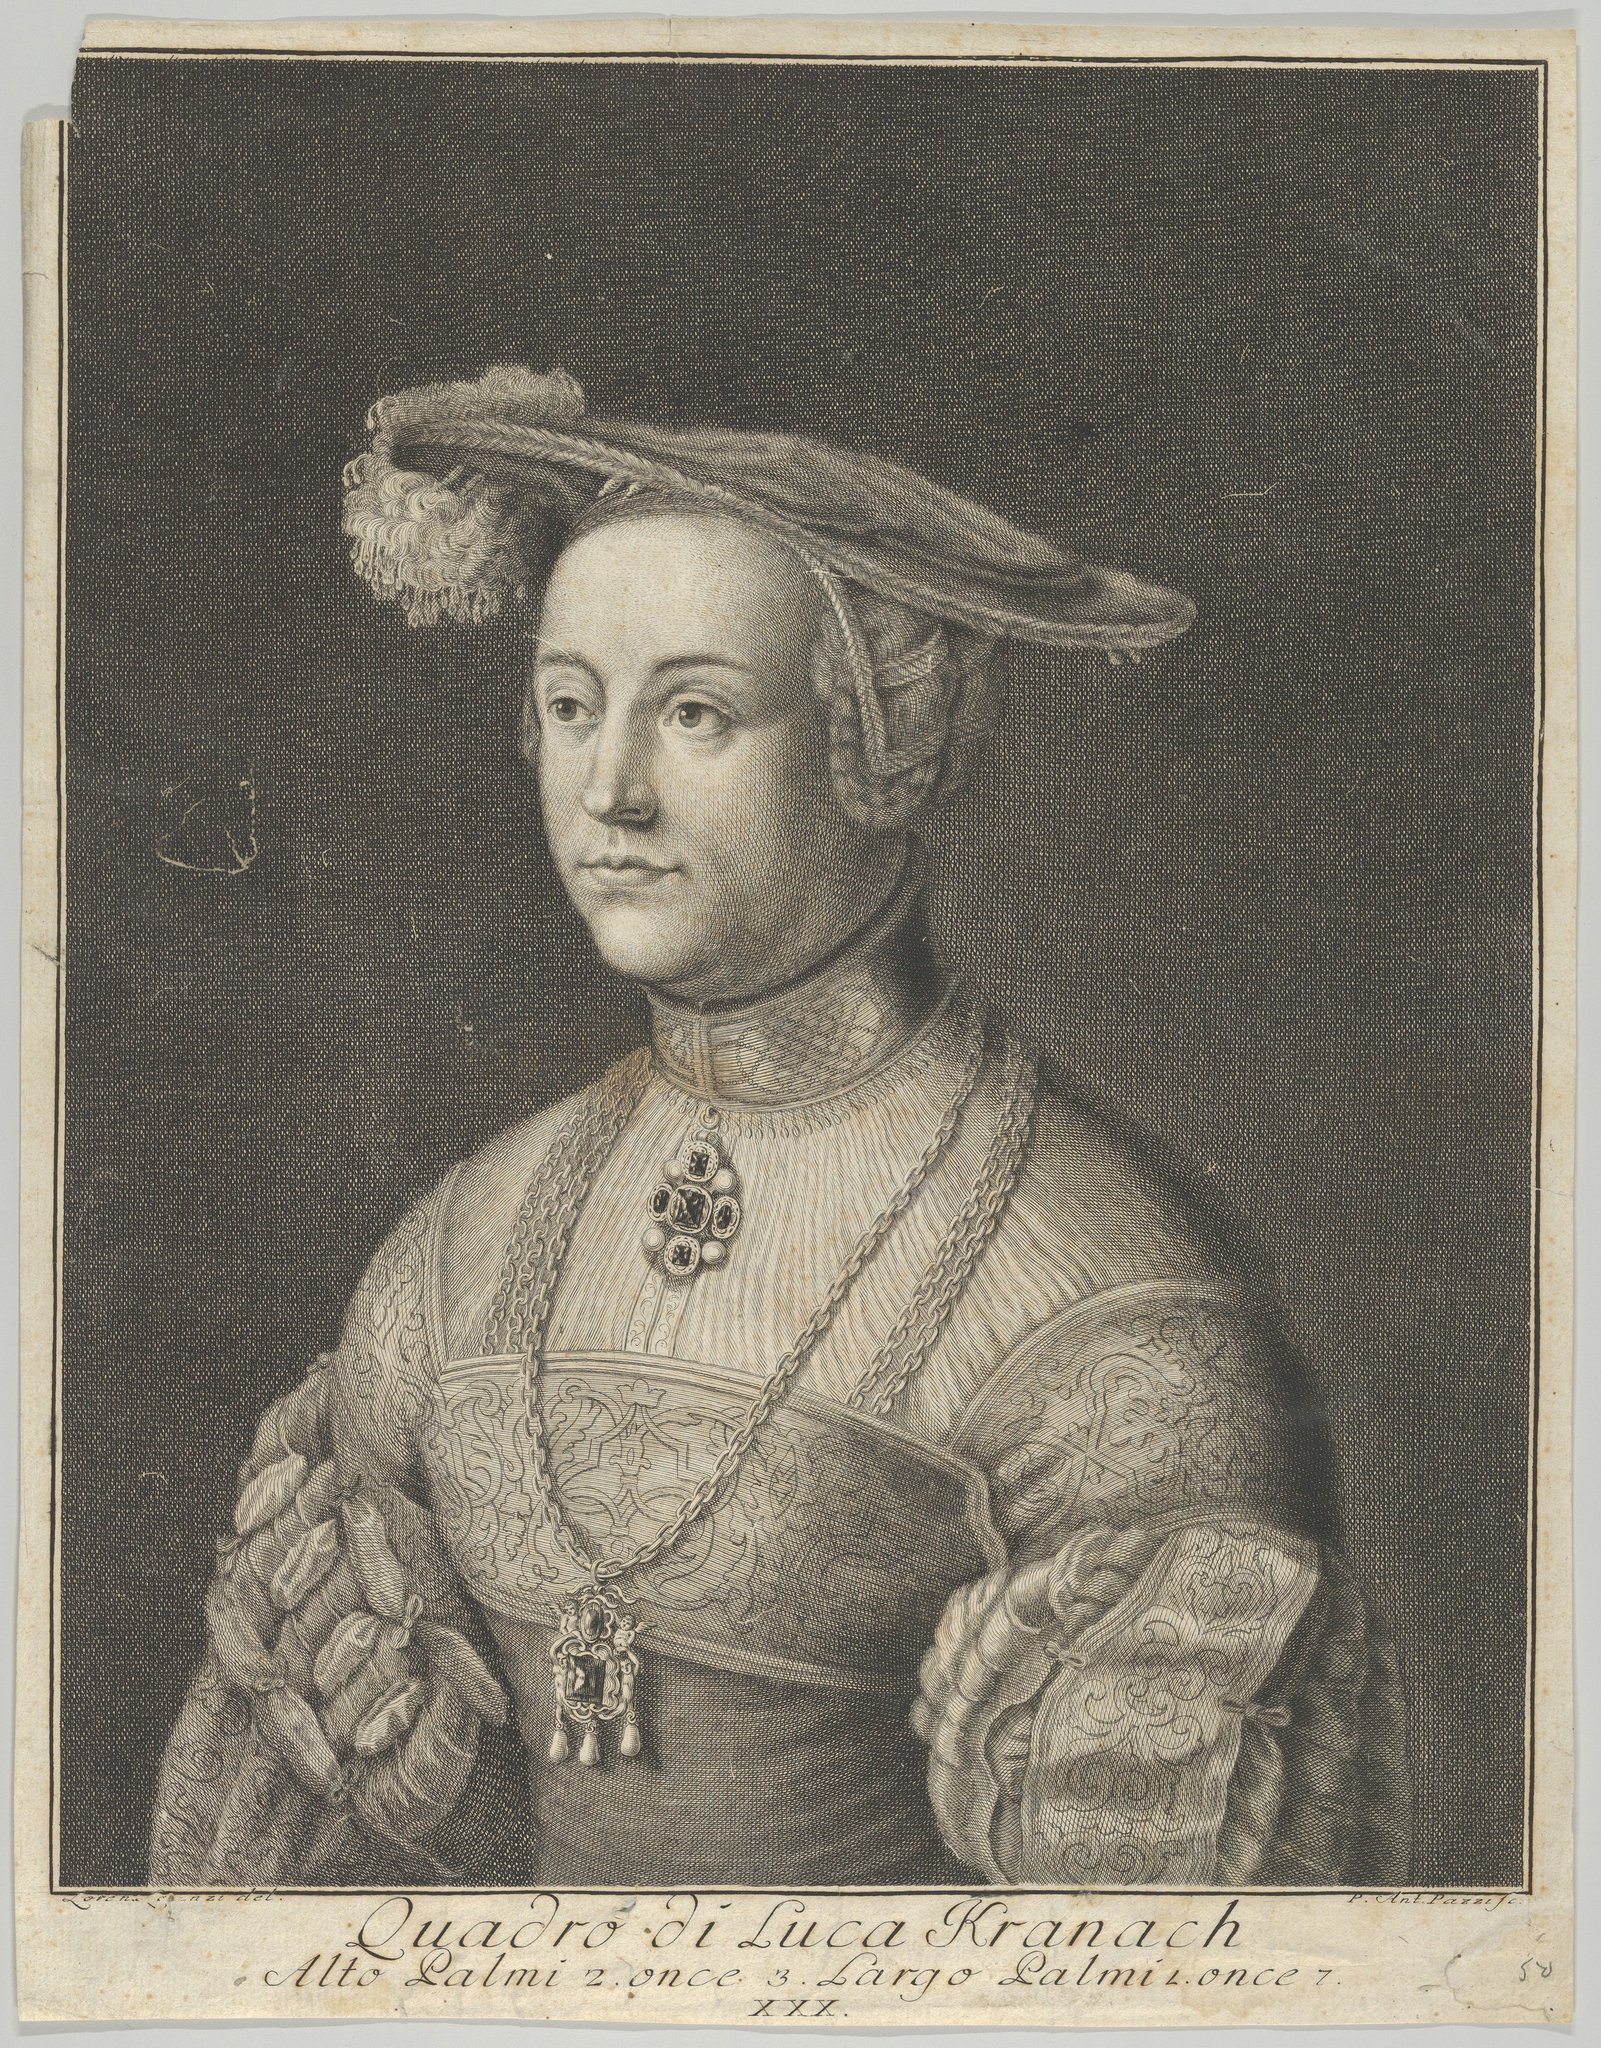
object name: print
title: Reproduction of Sibylla of Cleves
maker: lucas cranach the elder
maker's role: artist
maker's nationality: german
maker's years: 1472-1553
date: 1515-1586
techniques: engraving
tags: portraits,women